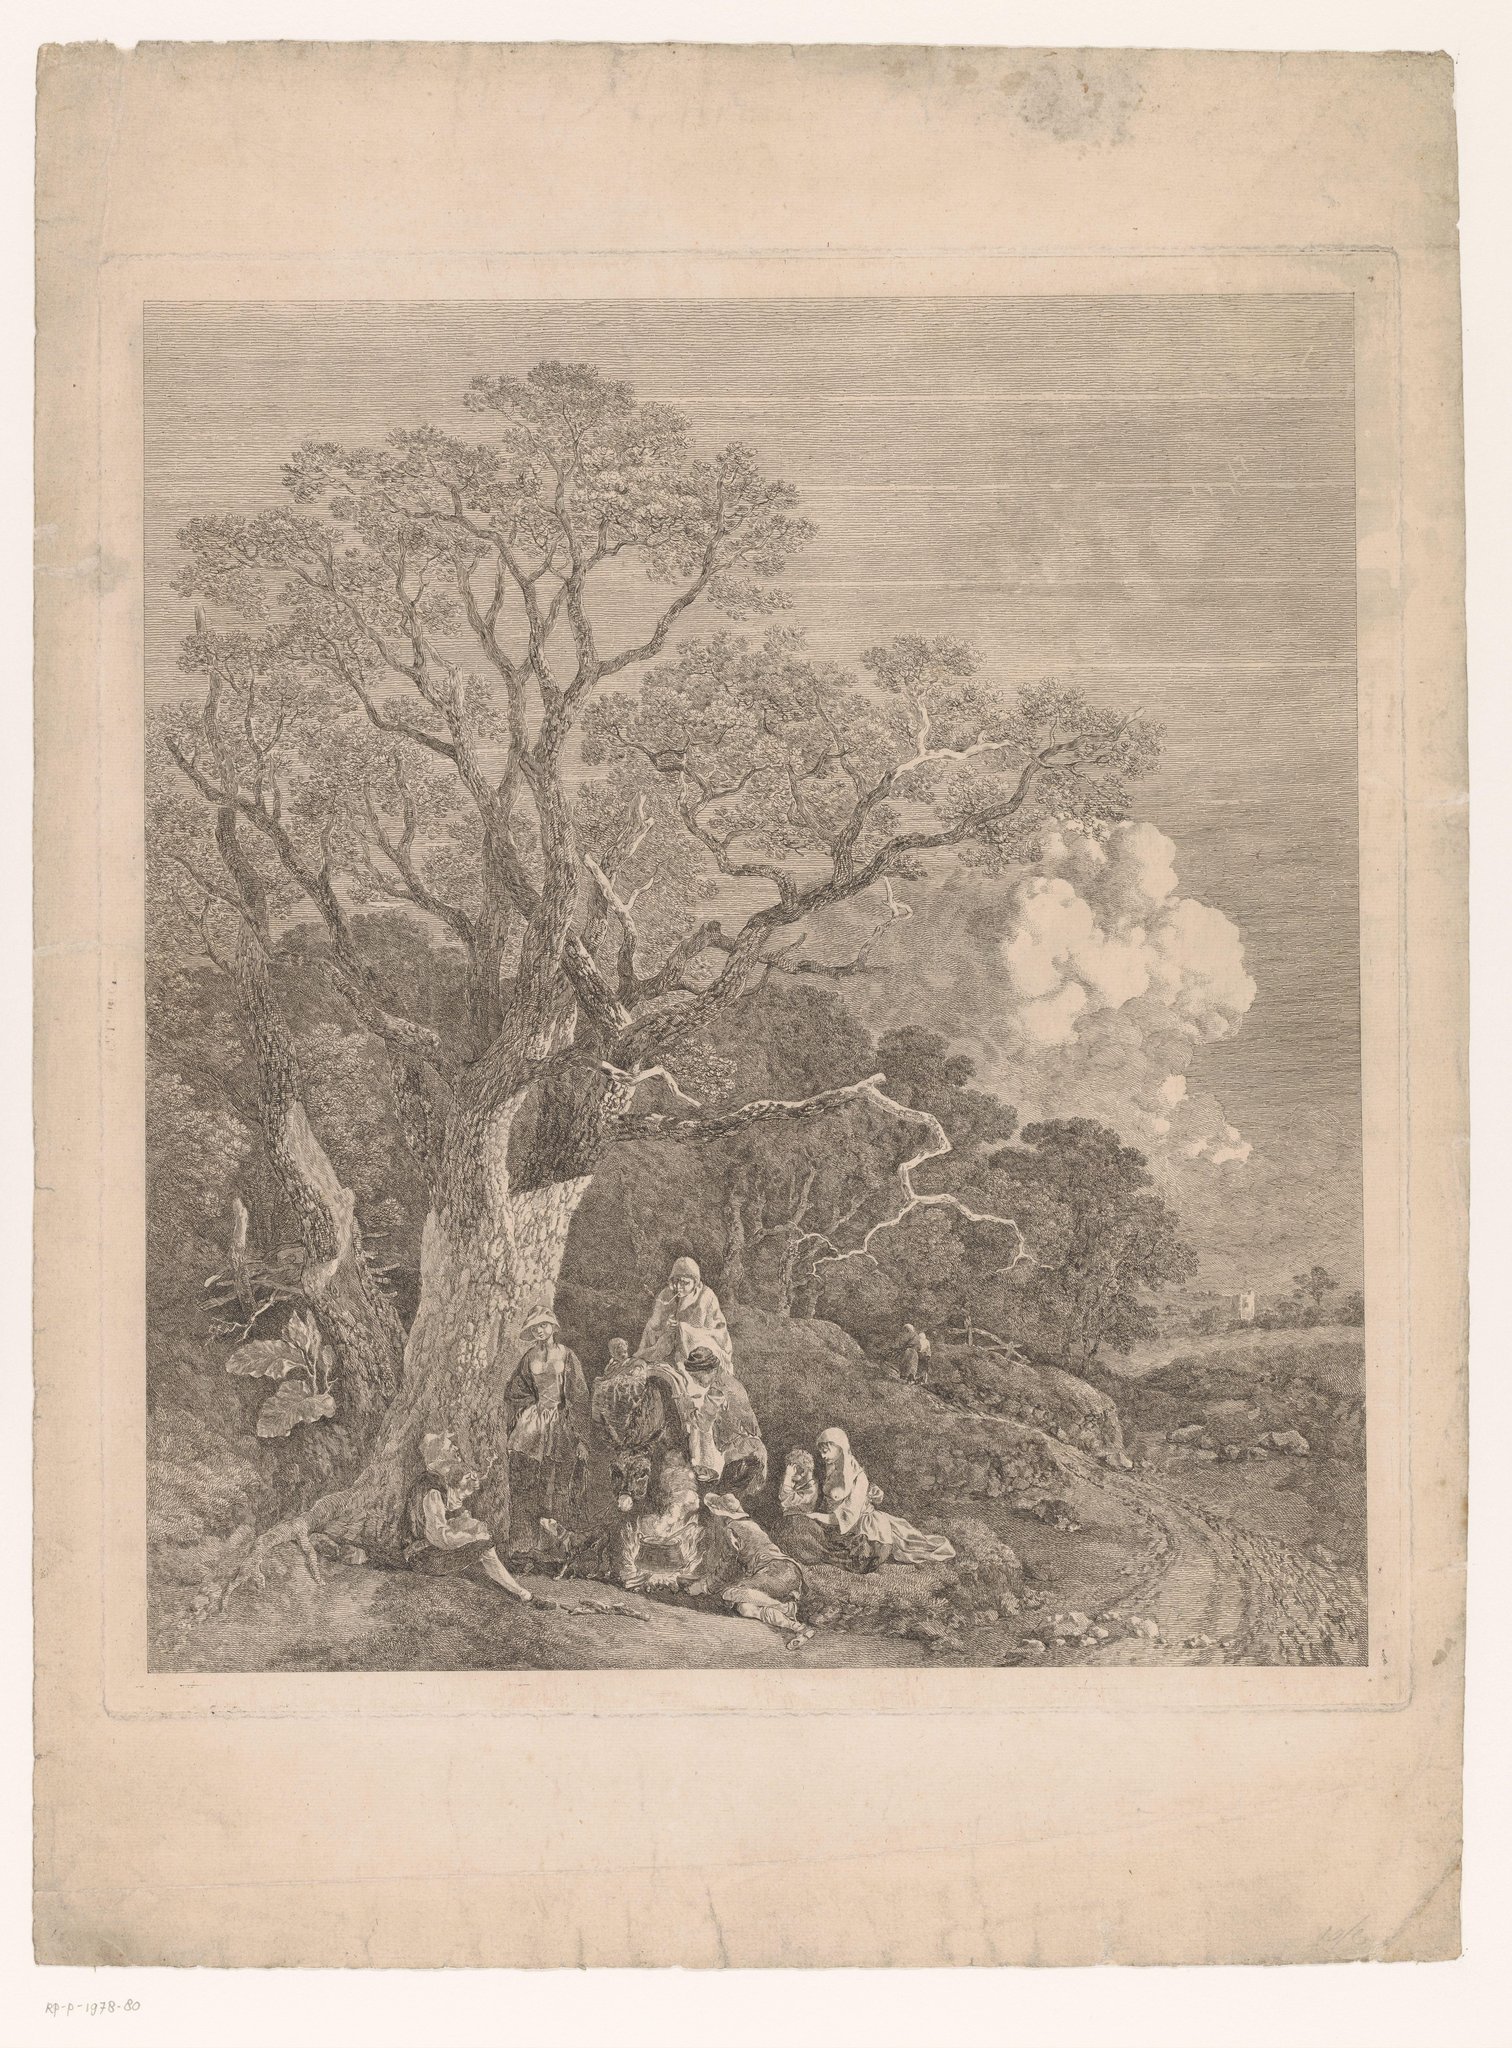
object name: print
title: Landschap met een groep reizigers onder een grote boom langs een bospad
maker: thomas gainsborough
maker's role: draughtsman, painter, print maker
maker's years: 1727-1788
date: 1753-1759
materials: paper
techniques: etching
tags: (traveller) resting in the open air, wandering communities: romani or roma, forest path or lane (+ landscape with figures, staffage)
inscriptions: collector's mark: Lugt 2760, collector's mark: Lugt 2228